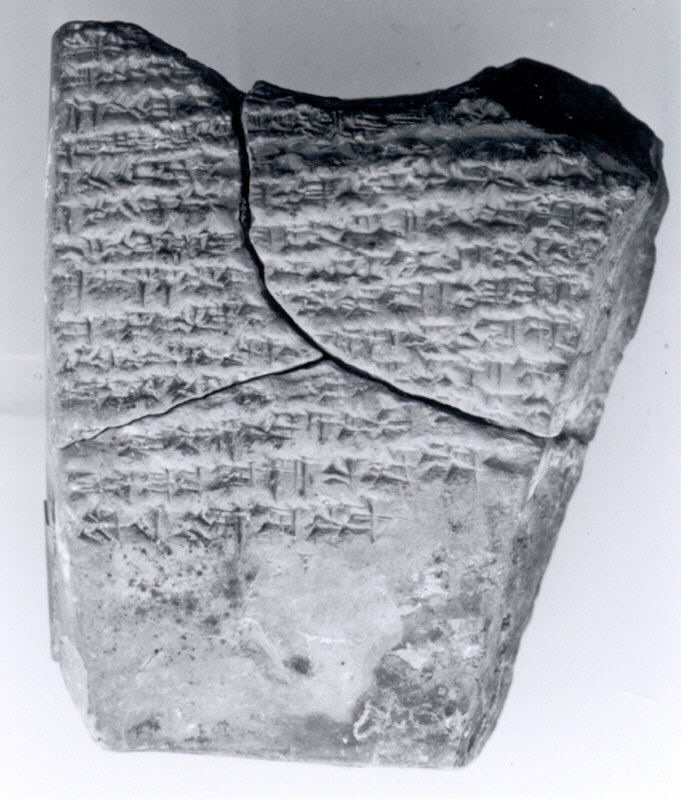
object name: cuneiform tablet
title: Cuneiform tablet: school exercise tablet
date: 333-1 BCE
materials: clay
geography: mesopotamia